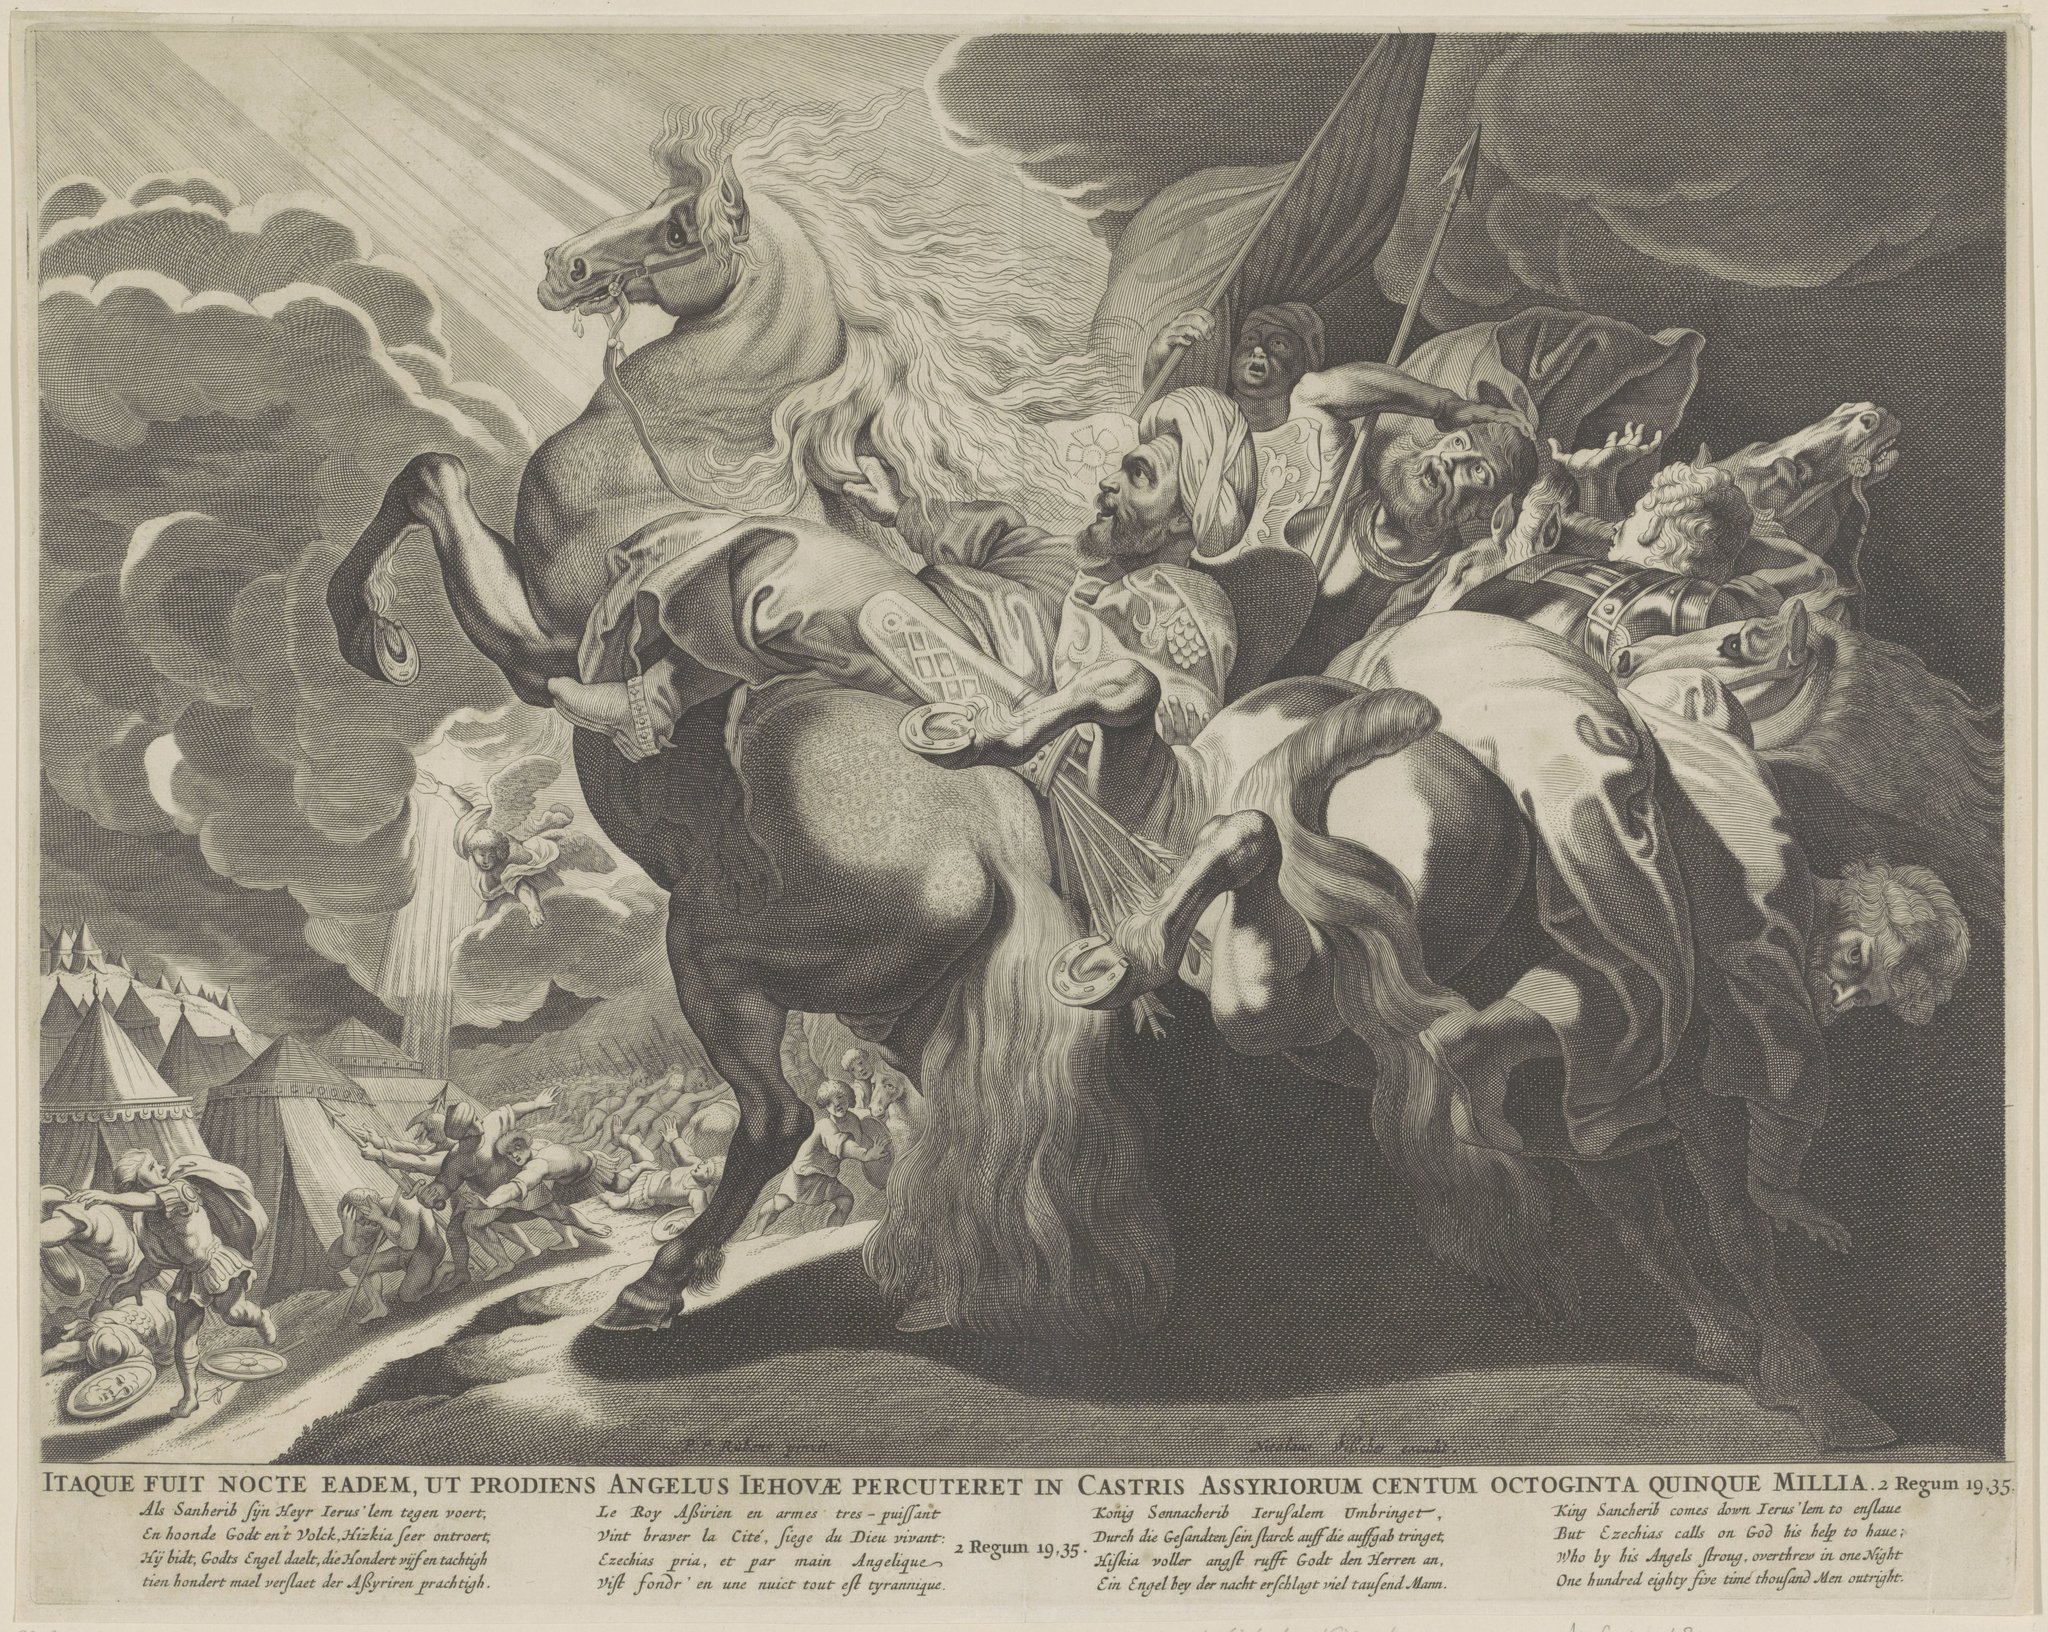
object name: print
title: De engel van de Heer doodt de Assyriërs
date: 1616-1657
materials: paper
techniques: engraving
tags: at night, an angel of the lord decimates the assyrian camp: 185.000 soldiers are killed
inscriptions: collector's mark: Lugt 2228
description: De Amsterdamse uitgever Claes Jansz. Visscher (II) produceerde vanaf de jaren ’30 van de zeventiende eeuw grote Bijbelse prenten op zogenaamd royaal-formaat papier (ca. 480 x 580 mm). Na zijn dood in 1652 zette zijn zoon Nicolaes Visscher (I) het bedrijf voort en zo ook de uitgave van Royaalbijbelprenten. Toen Nicolaes in 1679 overleed nam zijn zoon Nicolaes Visscher (II) het bedrijf over en gaf kort hierna, omstreeks 1680, een fondslijst uit. Hierin worden 130 prenten met Bijbelse voorstellingen op royaalpapier beschreven (zie documentatie J. van der Waals). Complete prentbijbels op royaal-formaat werden door vader en zoon Nicolaes Visscher uitgegeven onder de titel Historiae Sacrae Veteris et Novi Testamenti. De bladen werden echter ook los verkocht en konden worden gecombineerd met Royaalbijbel-prenten van andere uitgevers. Verschillende Amsterdamse uitgevers brachten namelijk ook bijbelprenten op royaal-formaat uit, onder wie Clement de Jonghe en Cornelis Danckerts. De door de firma Visscher uitgegeven prenten zijn veelal vervaardigd door anonieme prentmakers naar voorbeeld van verschillende zestiende- en zeventiende-eeuwse Bijbelse prenten en prentreeksen. Veelal moesten de composities worden aangepast aan het grotere en langgerekte royaal-formaat. Daarnaast zijn er ook grote bladen van bekende prentmakers zoals Jan van Londerseel, Pieter Nolpe, Jacques de Gheyn (II) en Jan Harmensz. Muller opgenomen in de categorie ‘Bybelsche Figuren, op Royaal-bladen’ in de fondslijst van Visscher. Prent mogelijk gebruikt in: Historiae Sacrae Veteris et Novi Testamenti (Royaalbijbel). Amsterdam: Nicolaes Visscher (I) en (II), [1652-1702]. In de fondslijst van Nicolaes Visscher II (ca. 1680) is het onderwerp van deze prent onder de titel 'Bybelsche Figuren, op Royaal-bladen. bestaande uyt de volgende historien.' als volgt genummerd: 54.